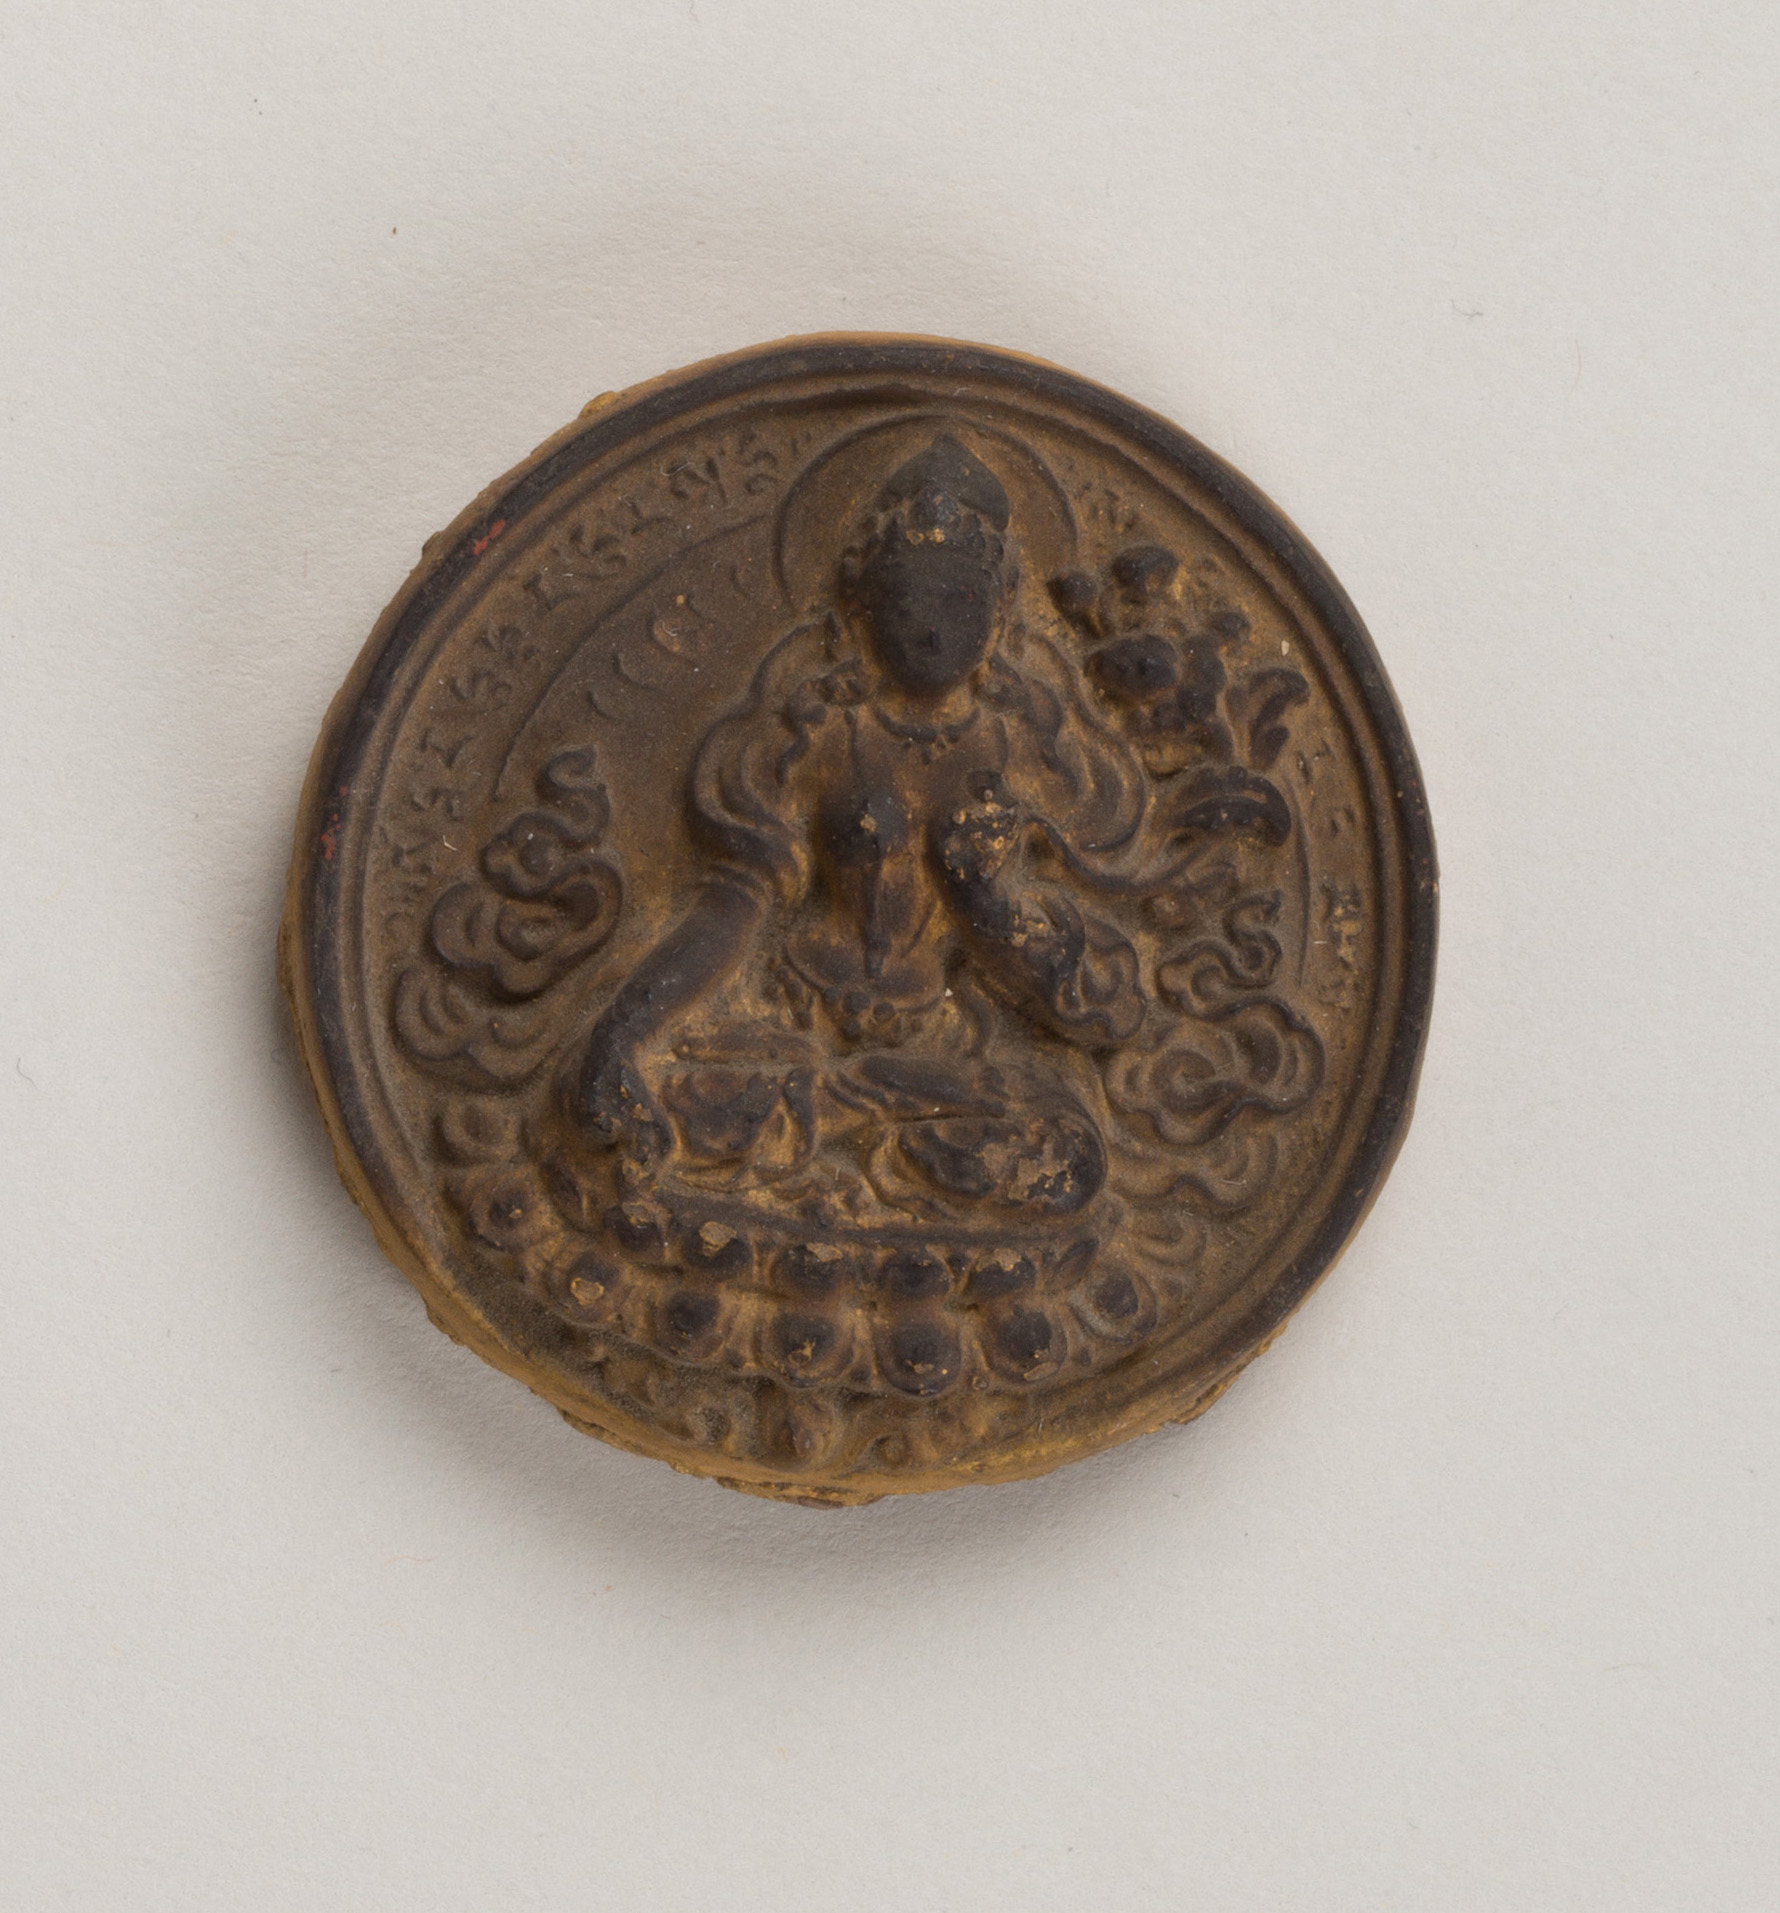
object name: plaque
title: Votive Plaque Showing Tara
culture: tibetan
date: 1501-1800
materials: clay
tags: goddess